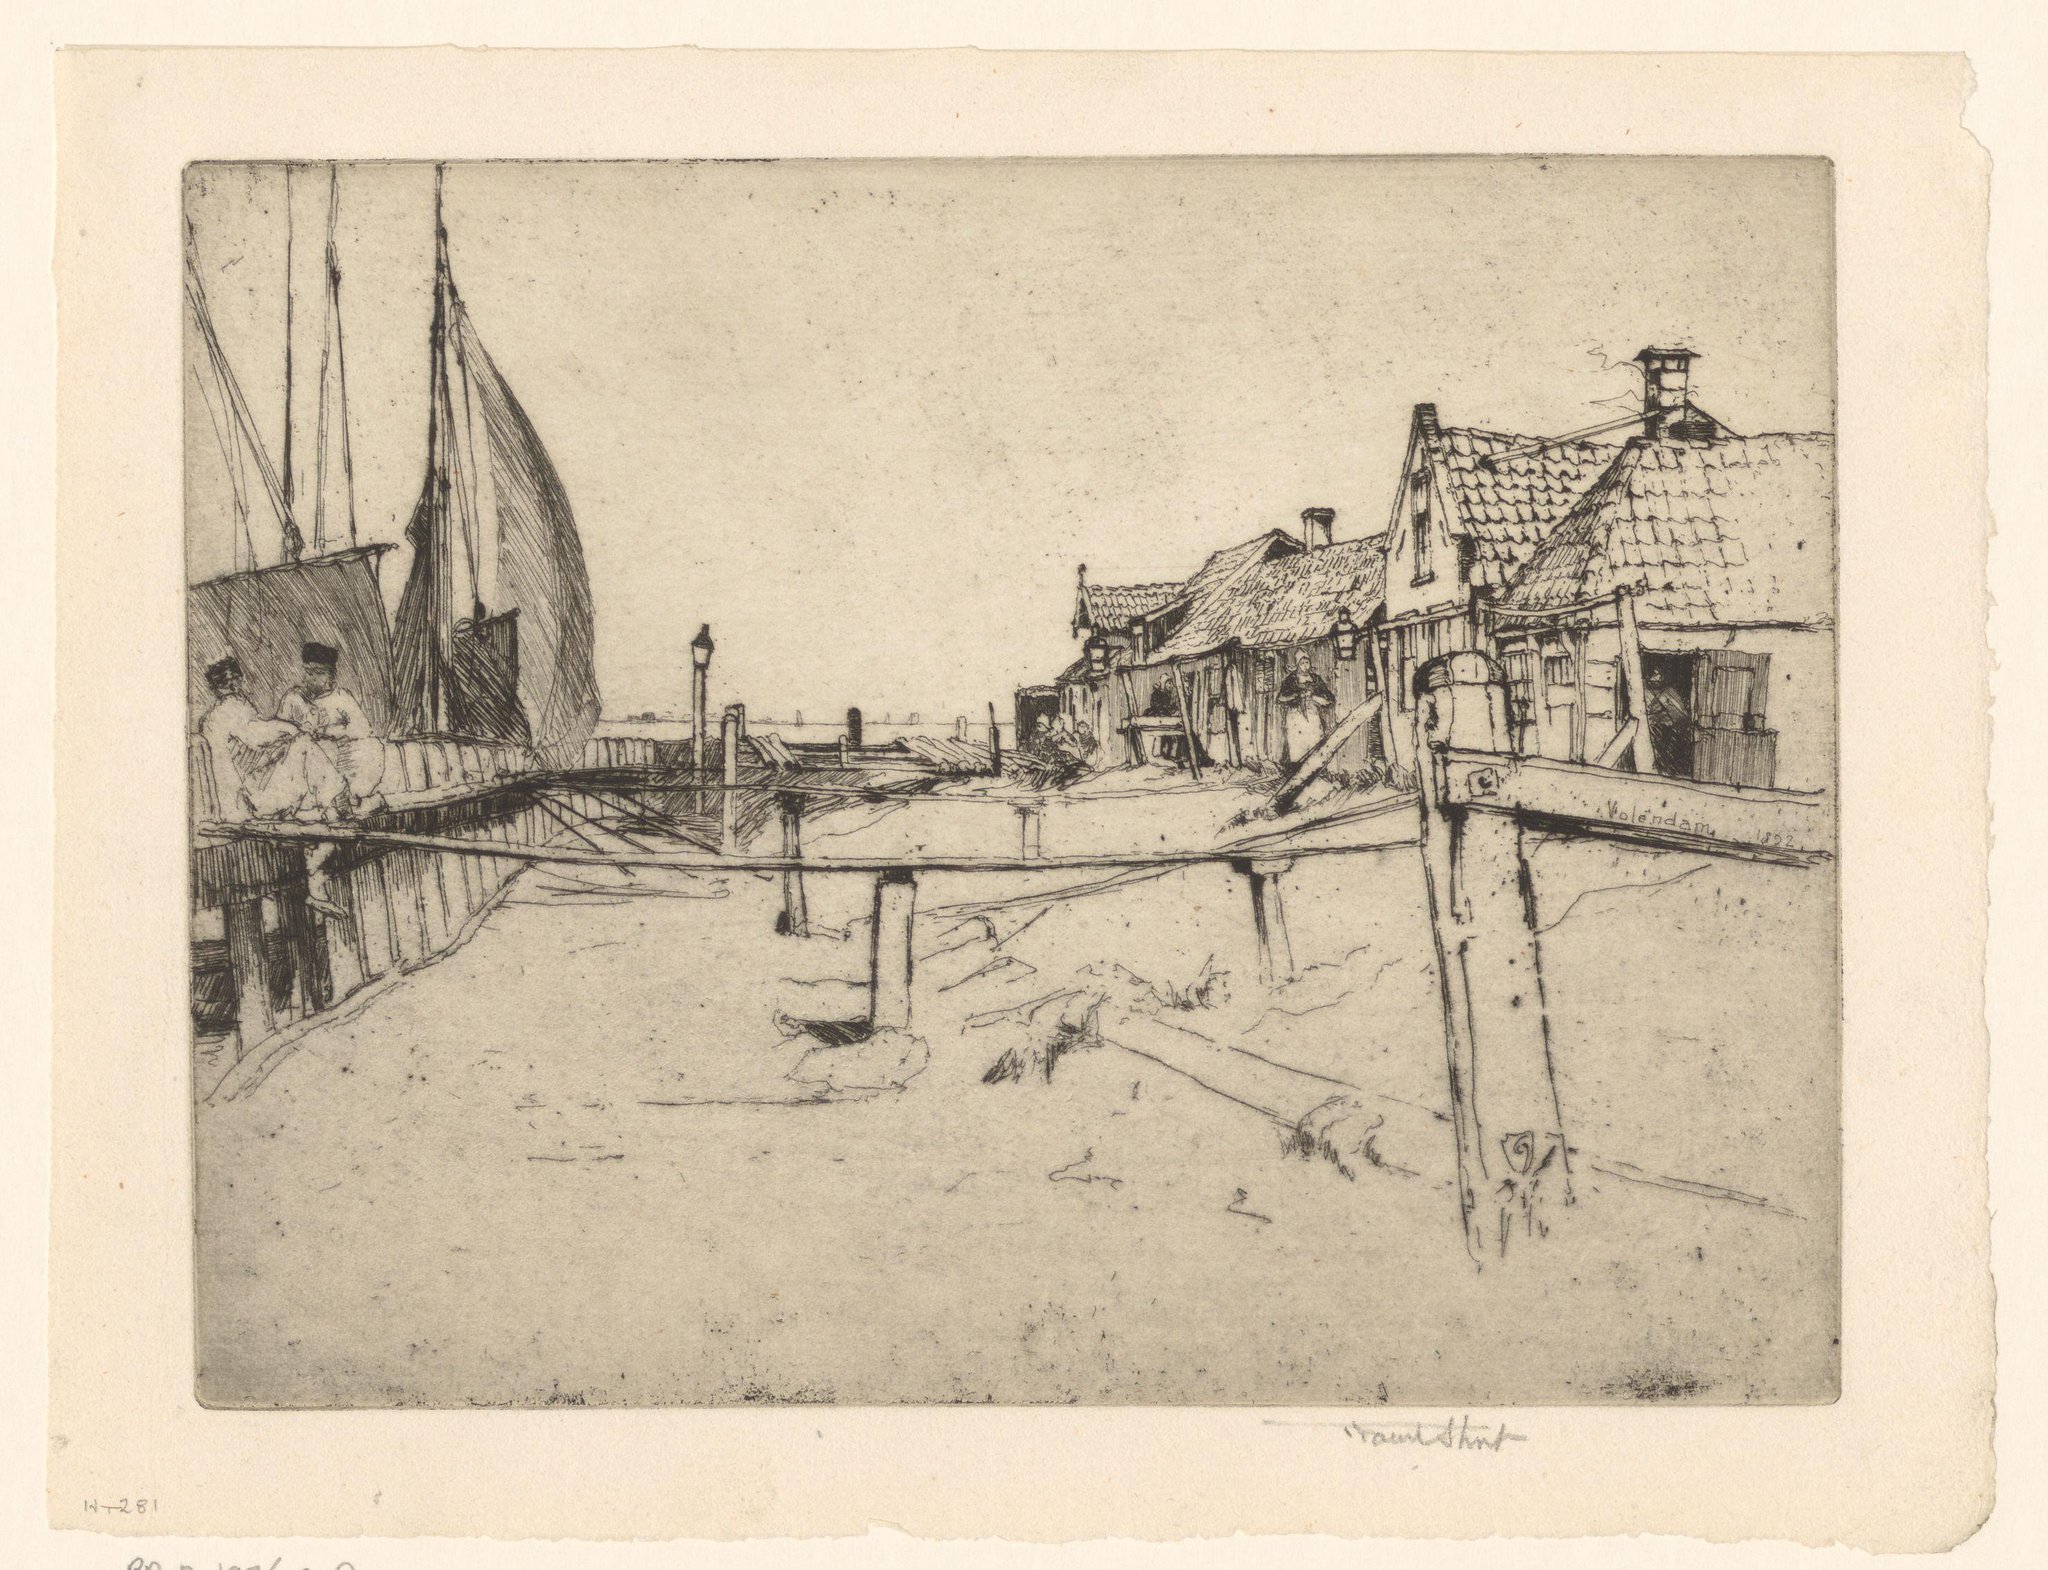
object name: print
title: In Port, Volendam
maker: frank short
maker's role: print maker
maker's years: 1857-1945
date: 1892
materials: paper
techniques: etching, intaglio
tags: harbour, sailing-ship, sailing-boat, cottage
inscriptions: collector's mark: Lugt 2760, collector's mark: Lugt 2228, signature: ‘Frank Short’